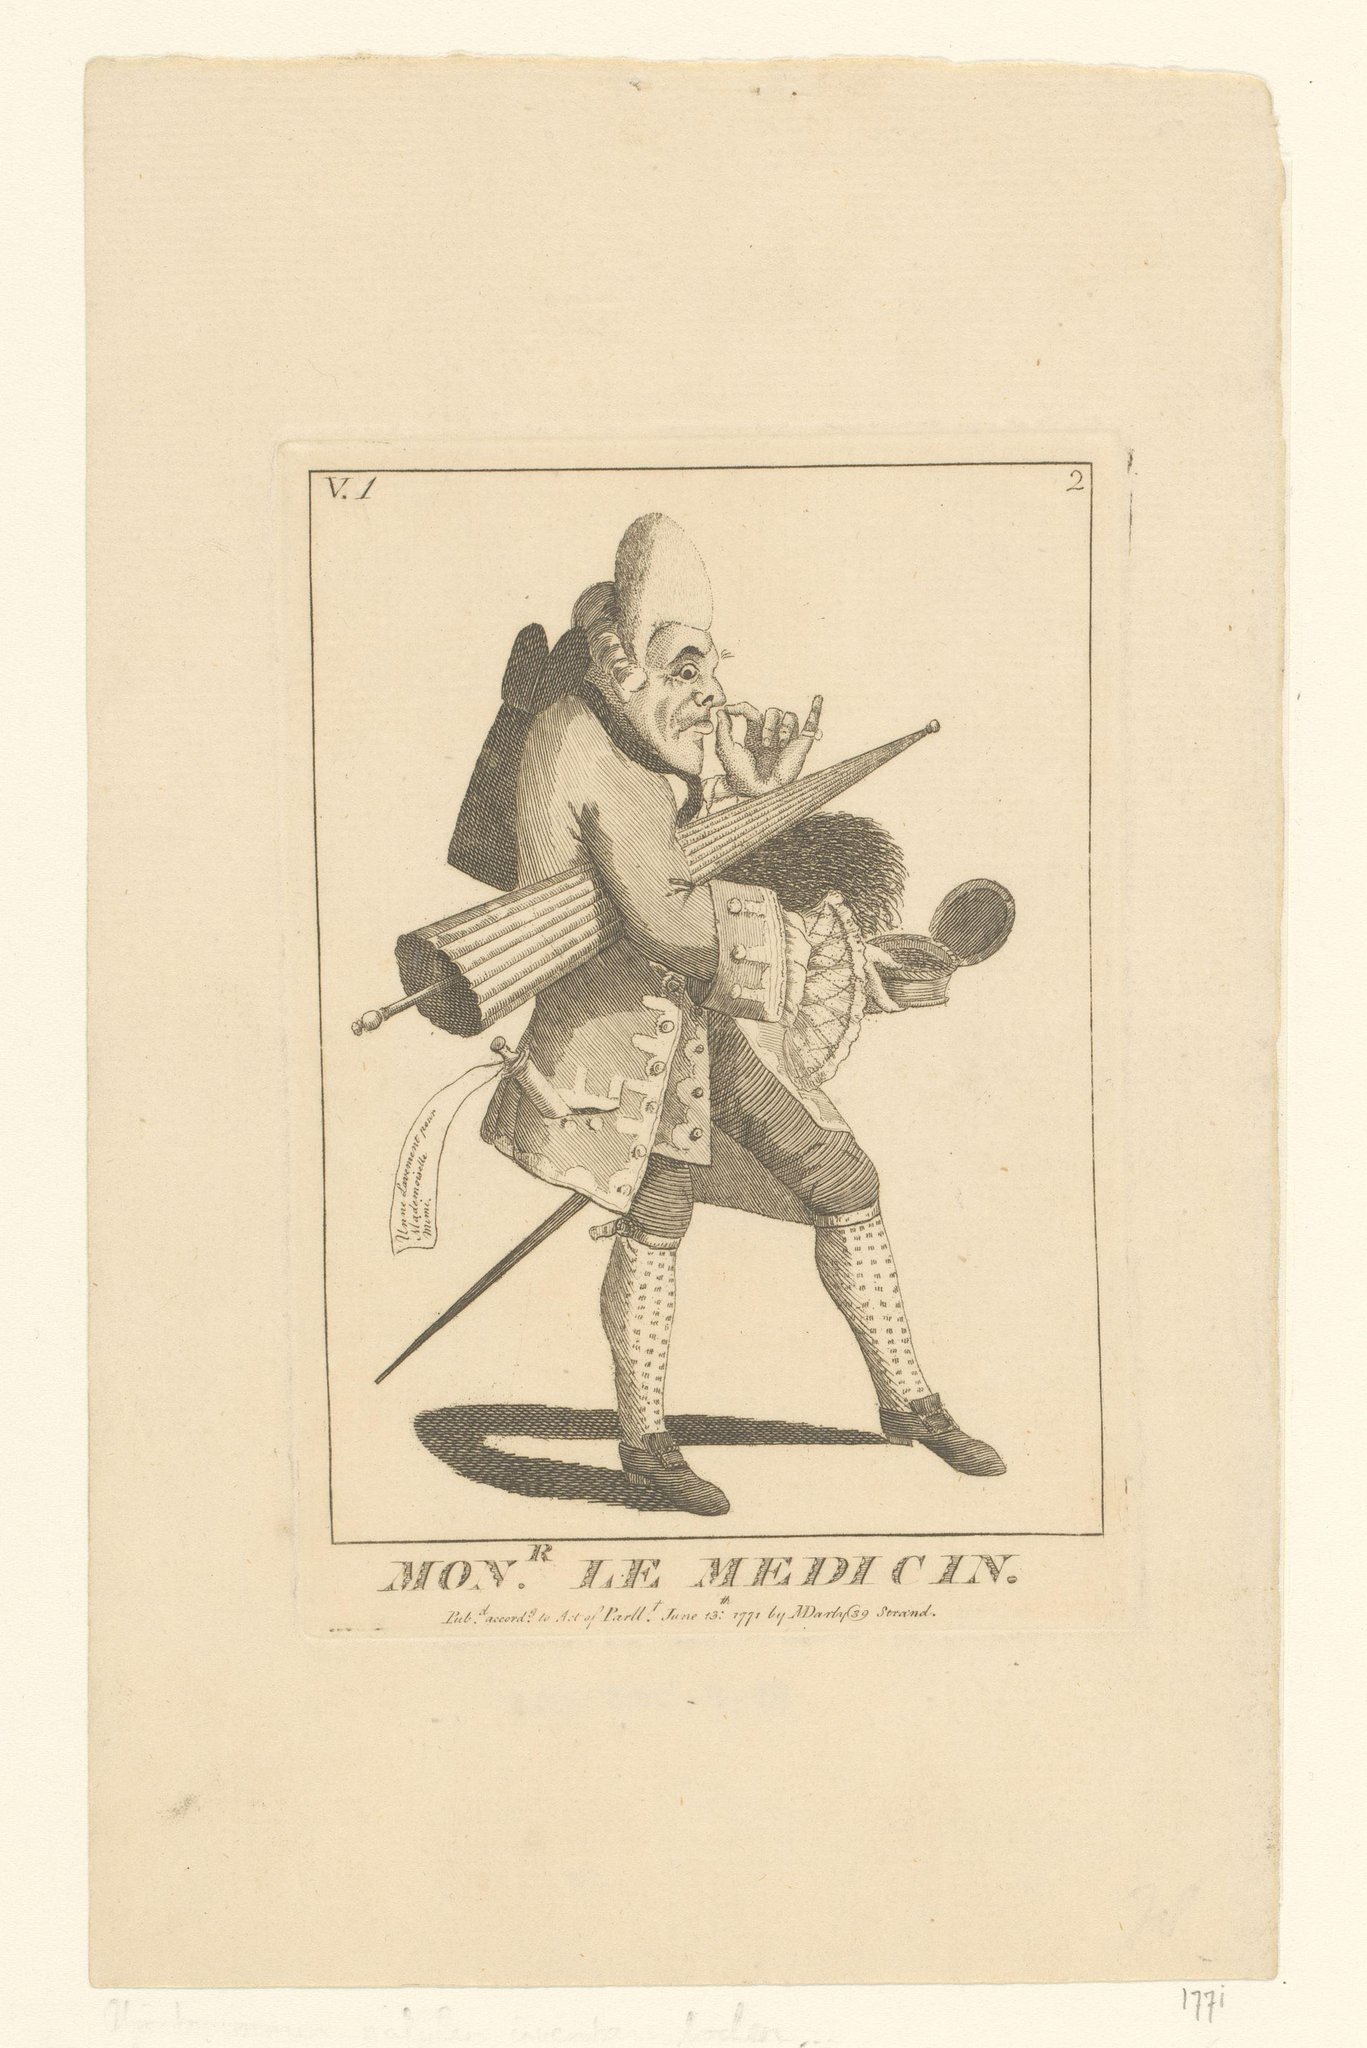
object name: print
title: 24 Caricatures by Several Ladies, Gentleman, Artists, &c.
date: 1771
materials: paper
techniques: engraving, etching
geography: london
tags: snuff-box, physician, doctor, political caricatures and satires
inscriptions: collector's mark: Lugt 2228, : ‘Pub[lishe]d accord[in]g to Act of Parll[iamen]t.’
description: Maakt deel uit van een 24-delige serie met karikaturen van verschillende figuren, uitgegeven door Matthew en Mary Darly in 1771. Dit betreft een prent uit volume 1 van de serie.